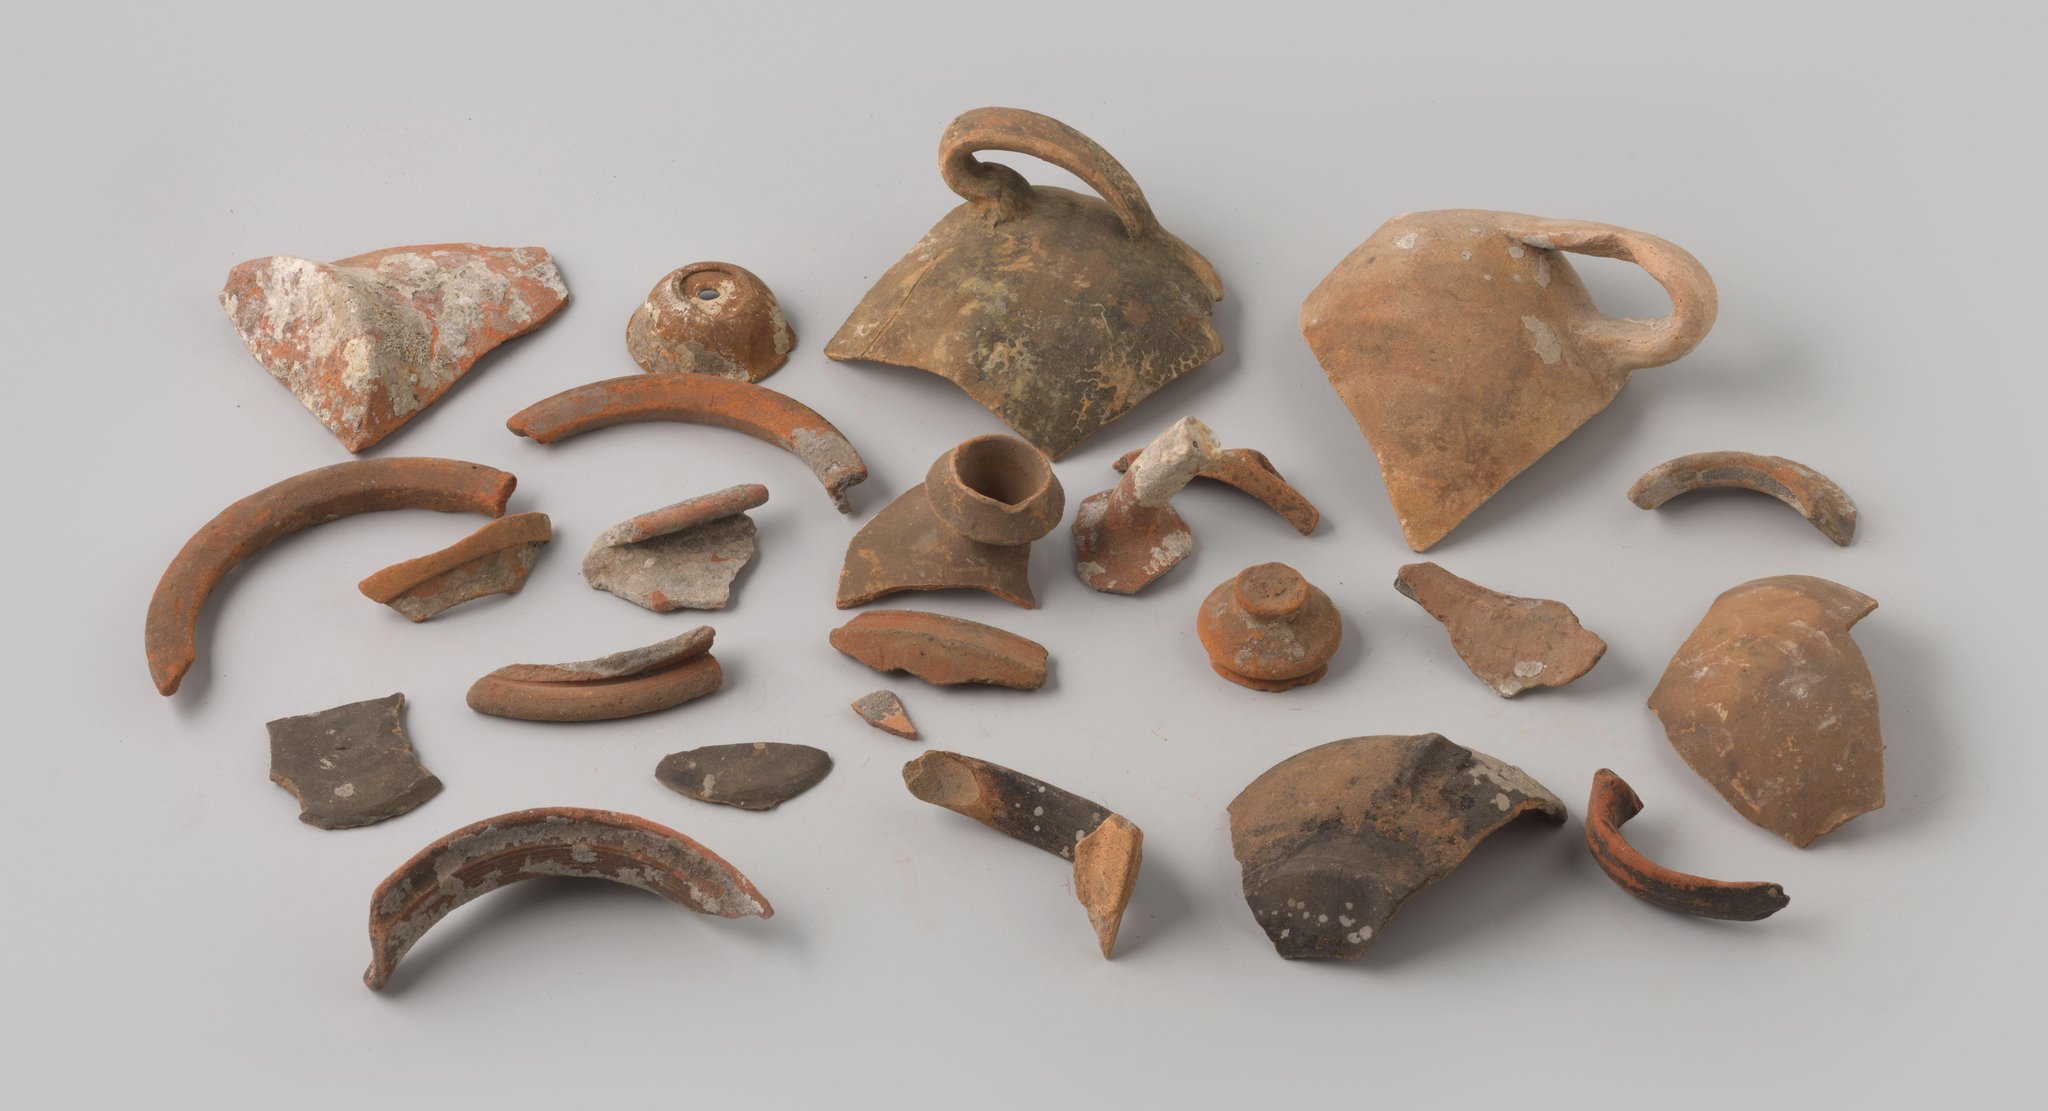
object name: sherd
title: Zak met scherven van aardewerk uit V.O.C.-schip de 'Witte Leeuw'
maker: Anonymous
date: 1613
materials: earthenware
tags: verenigde oostindische compagnie, sint-helena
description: Zak met scherven van roodbakkend en geelbakkend aardewerk uit V.O.C.-schip de 'Witte Leeuw'. Fragmenten van oren, bodems, dekels en randen.